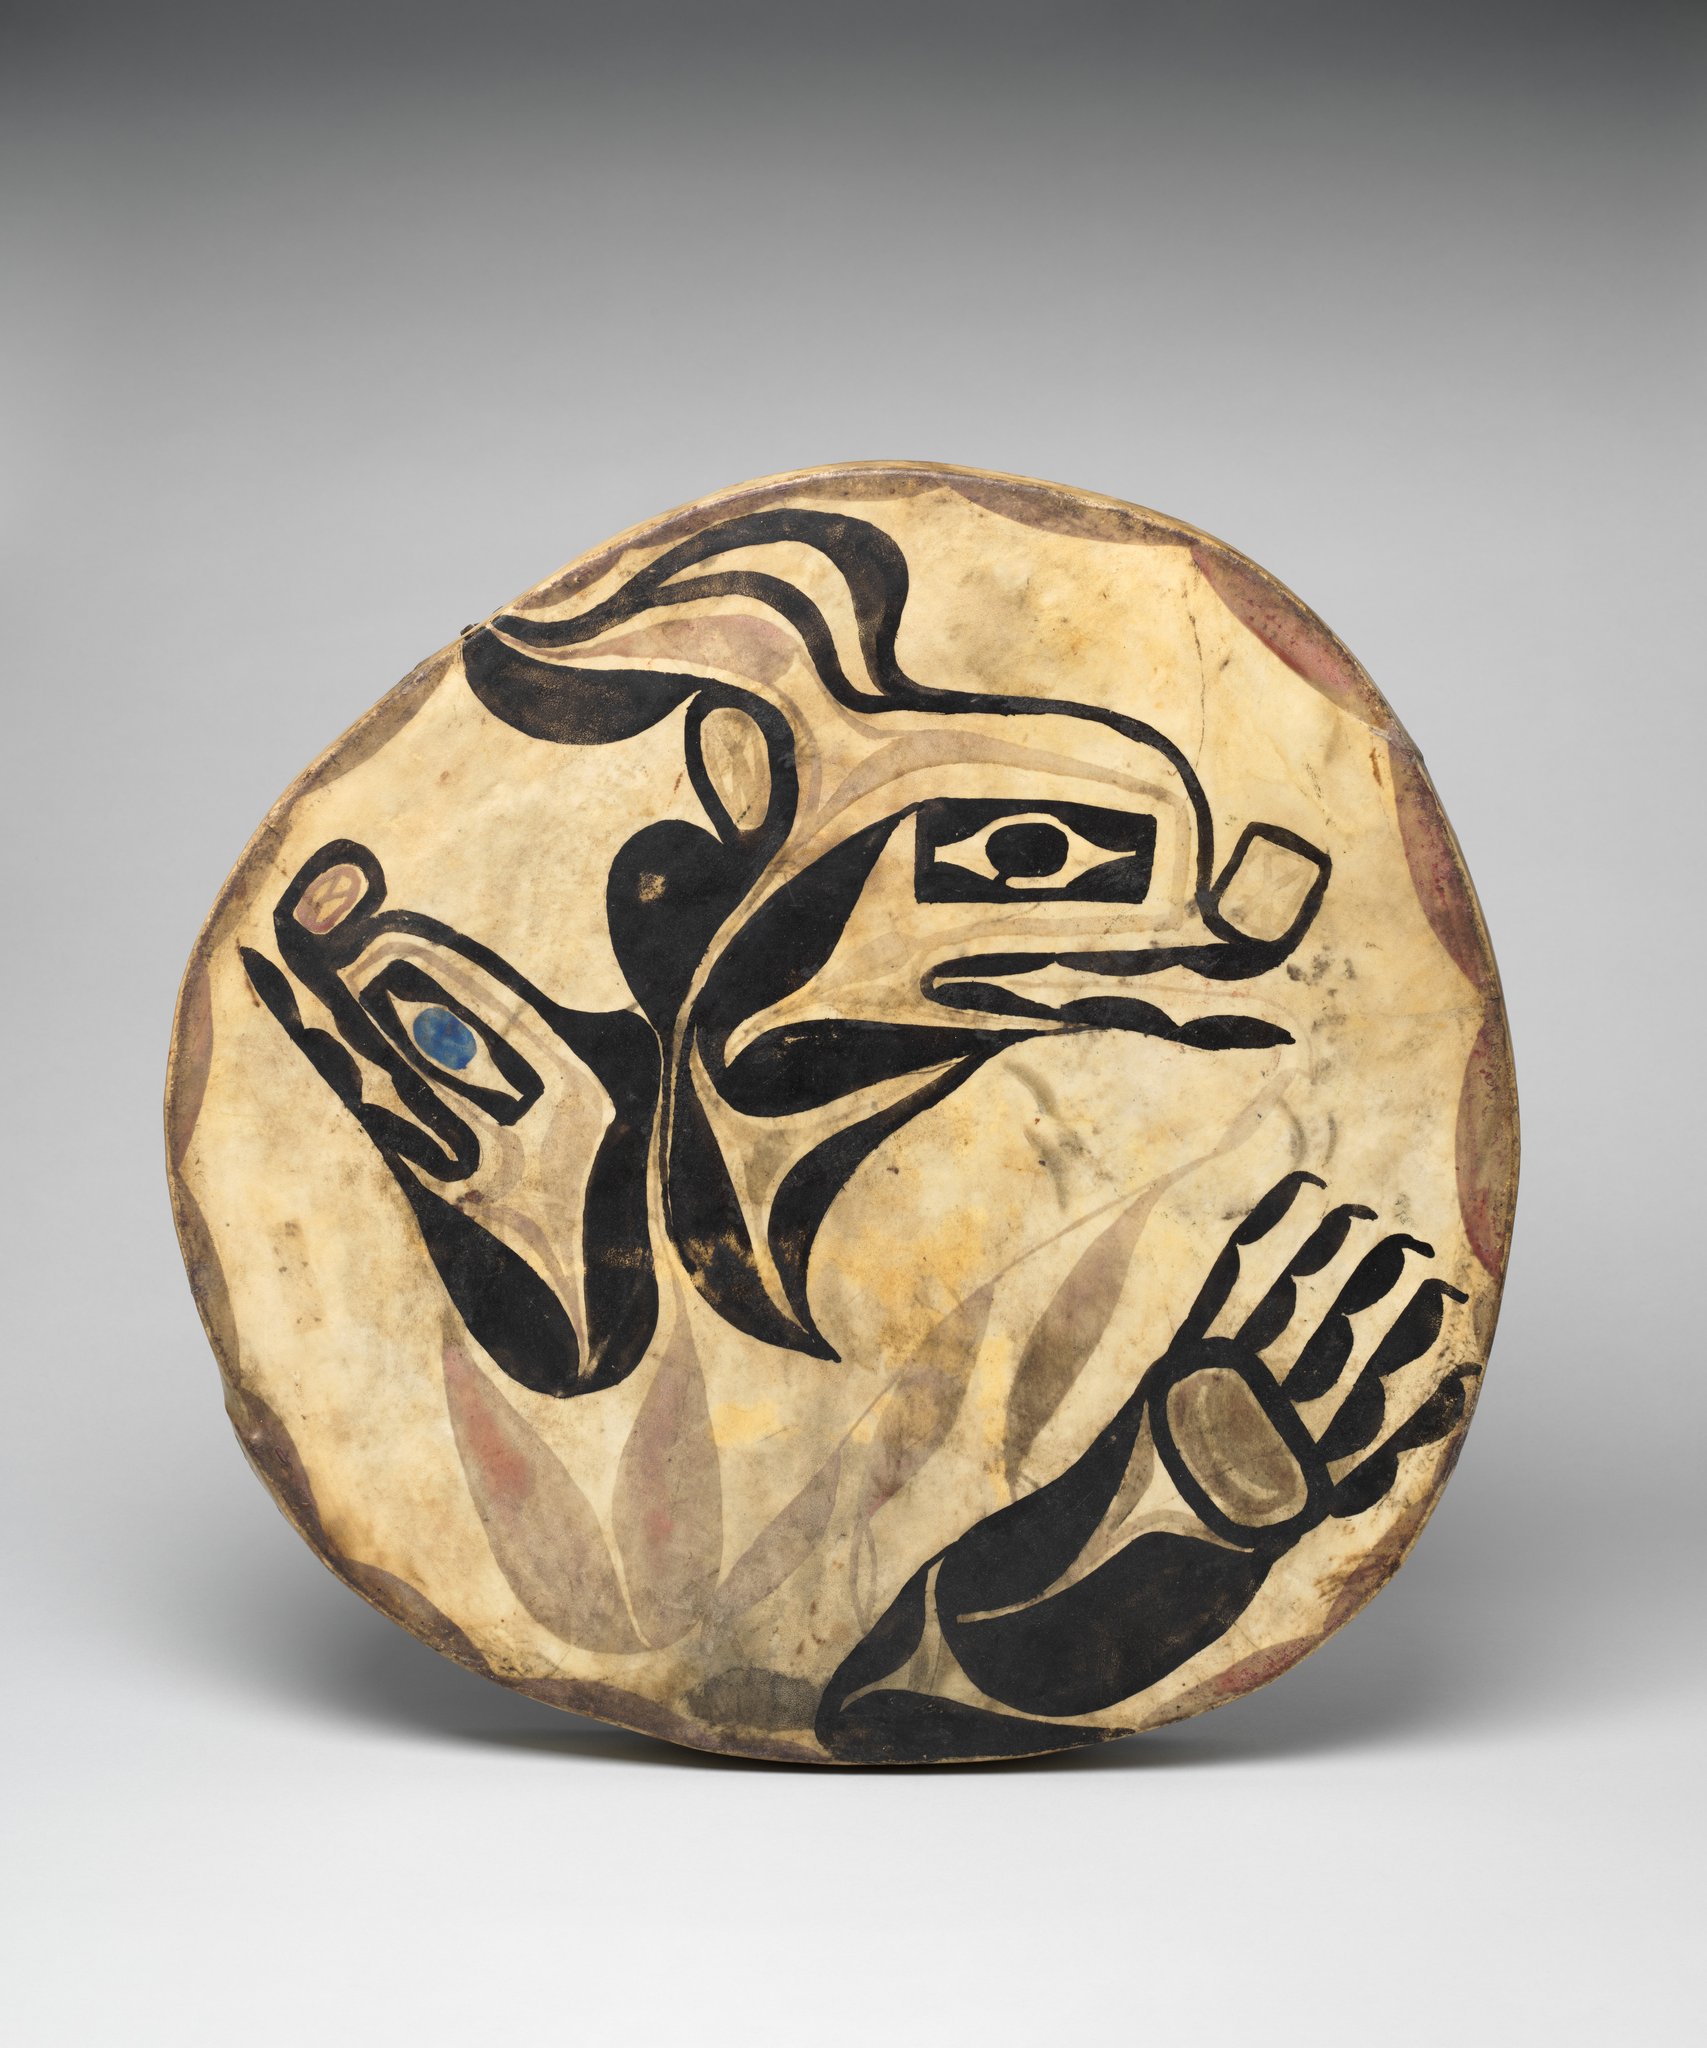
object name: cauyuk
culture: native american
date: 1801-1900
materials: wood, pigment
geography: canada